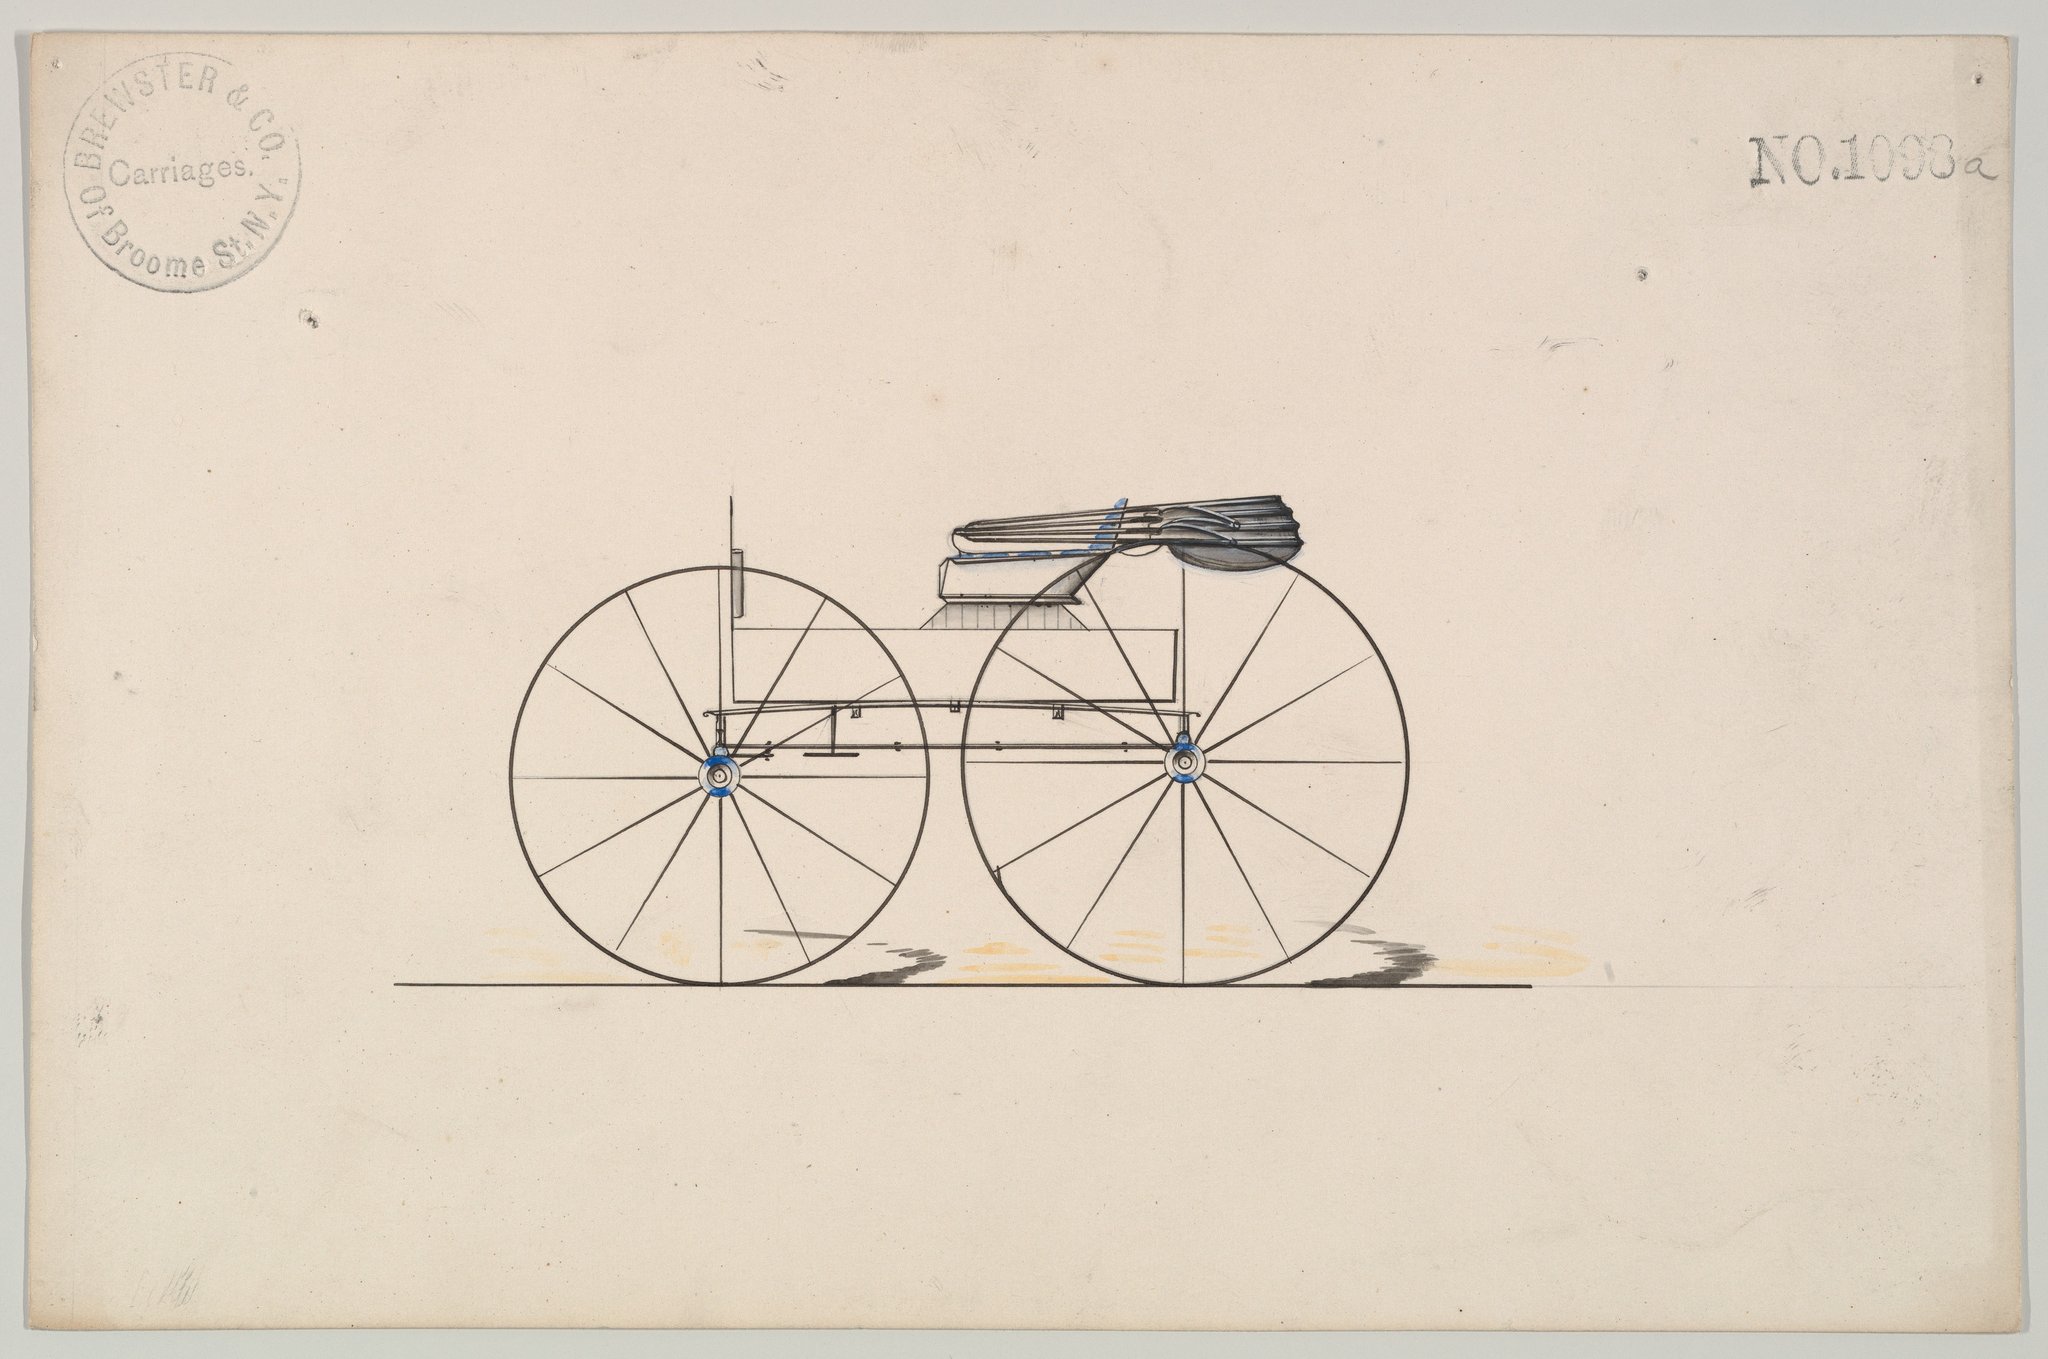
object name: drawing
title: Design for Wagon, no. 1098a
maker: brewster & co.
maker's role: manufacturer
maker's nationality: american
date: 1850-1870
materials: gouache, gum arabic, ink, watercolor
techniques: pen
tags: carriages